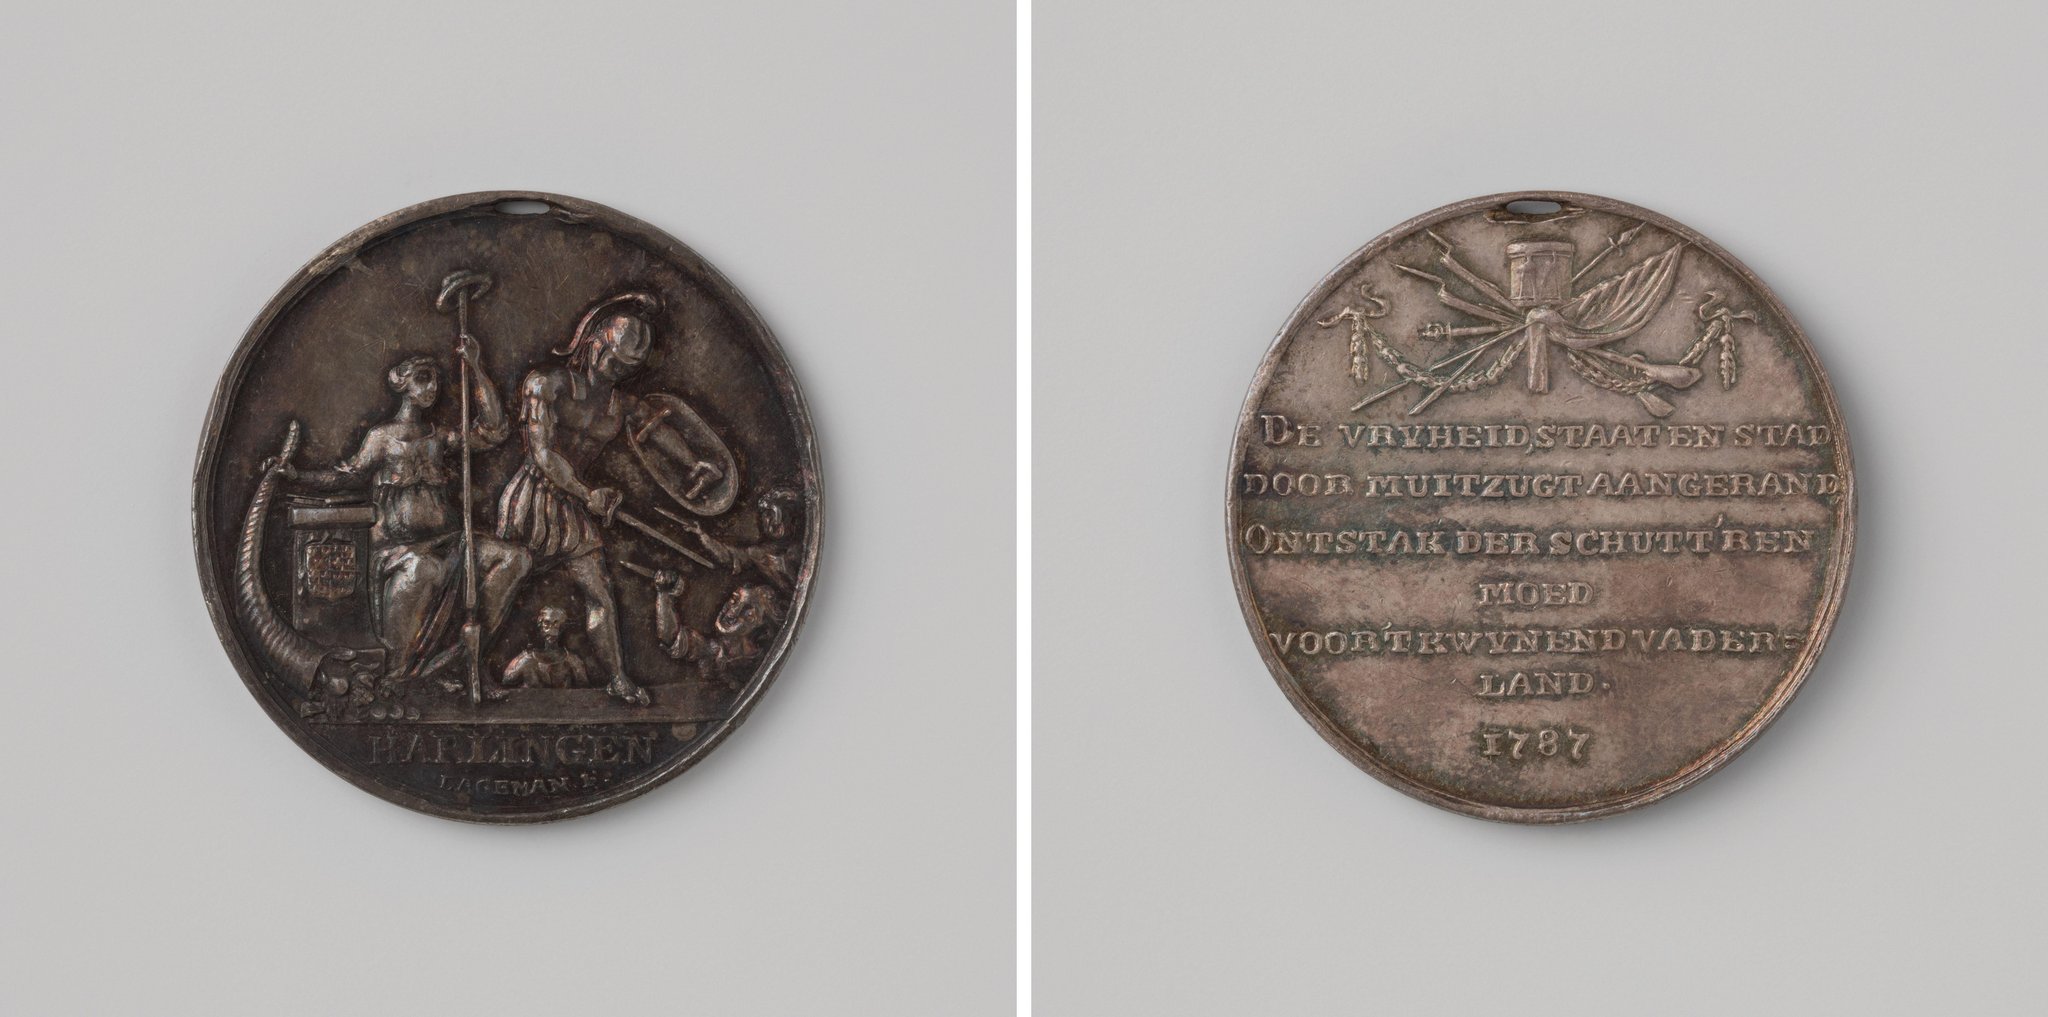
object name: honorary medal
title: Stillen van het oproer te Harlingen, penning uitgereikt aan de schutters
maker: johannes michiel lageman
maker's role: silversmith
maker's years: 1735-1809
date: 1787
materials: silver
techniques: striking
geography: amsterdam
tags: harlingen